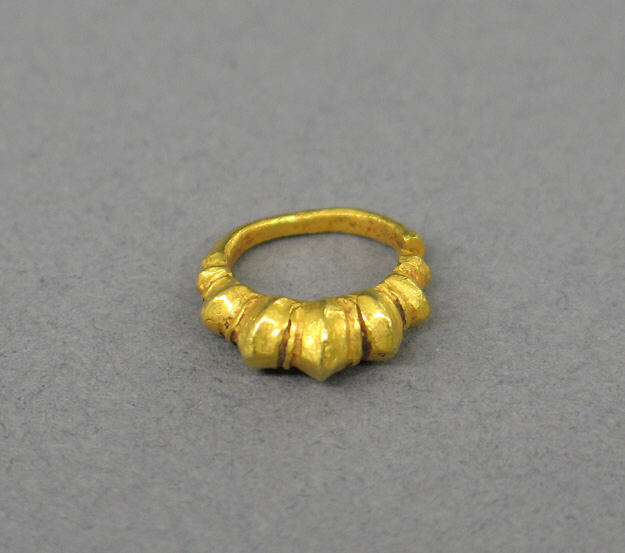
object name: ear clip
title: Pair of Ear Clips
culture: indonesian, javanese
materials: gold